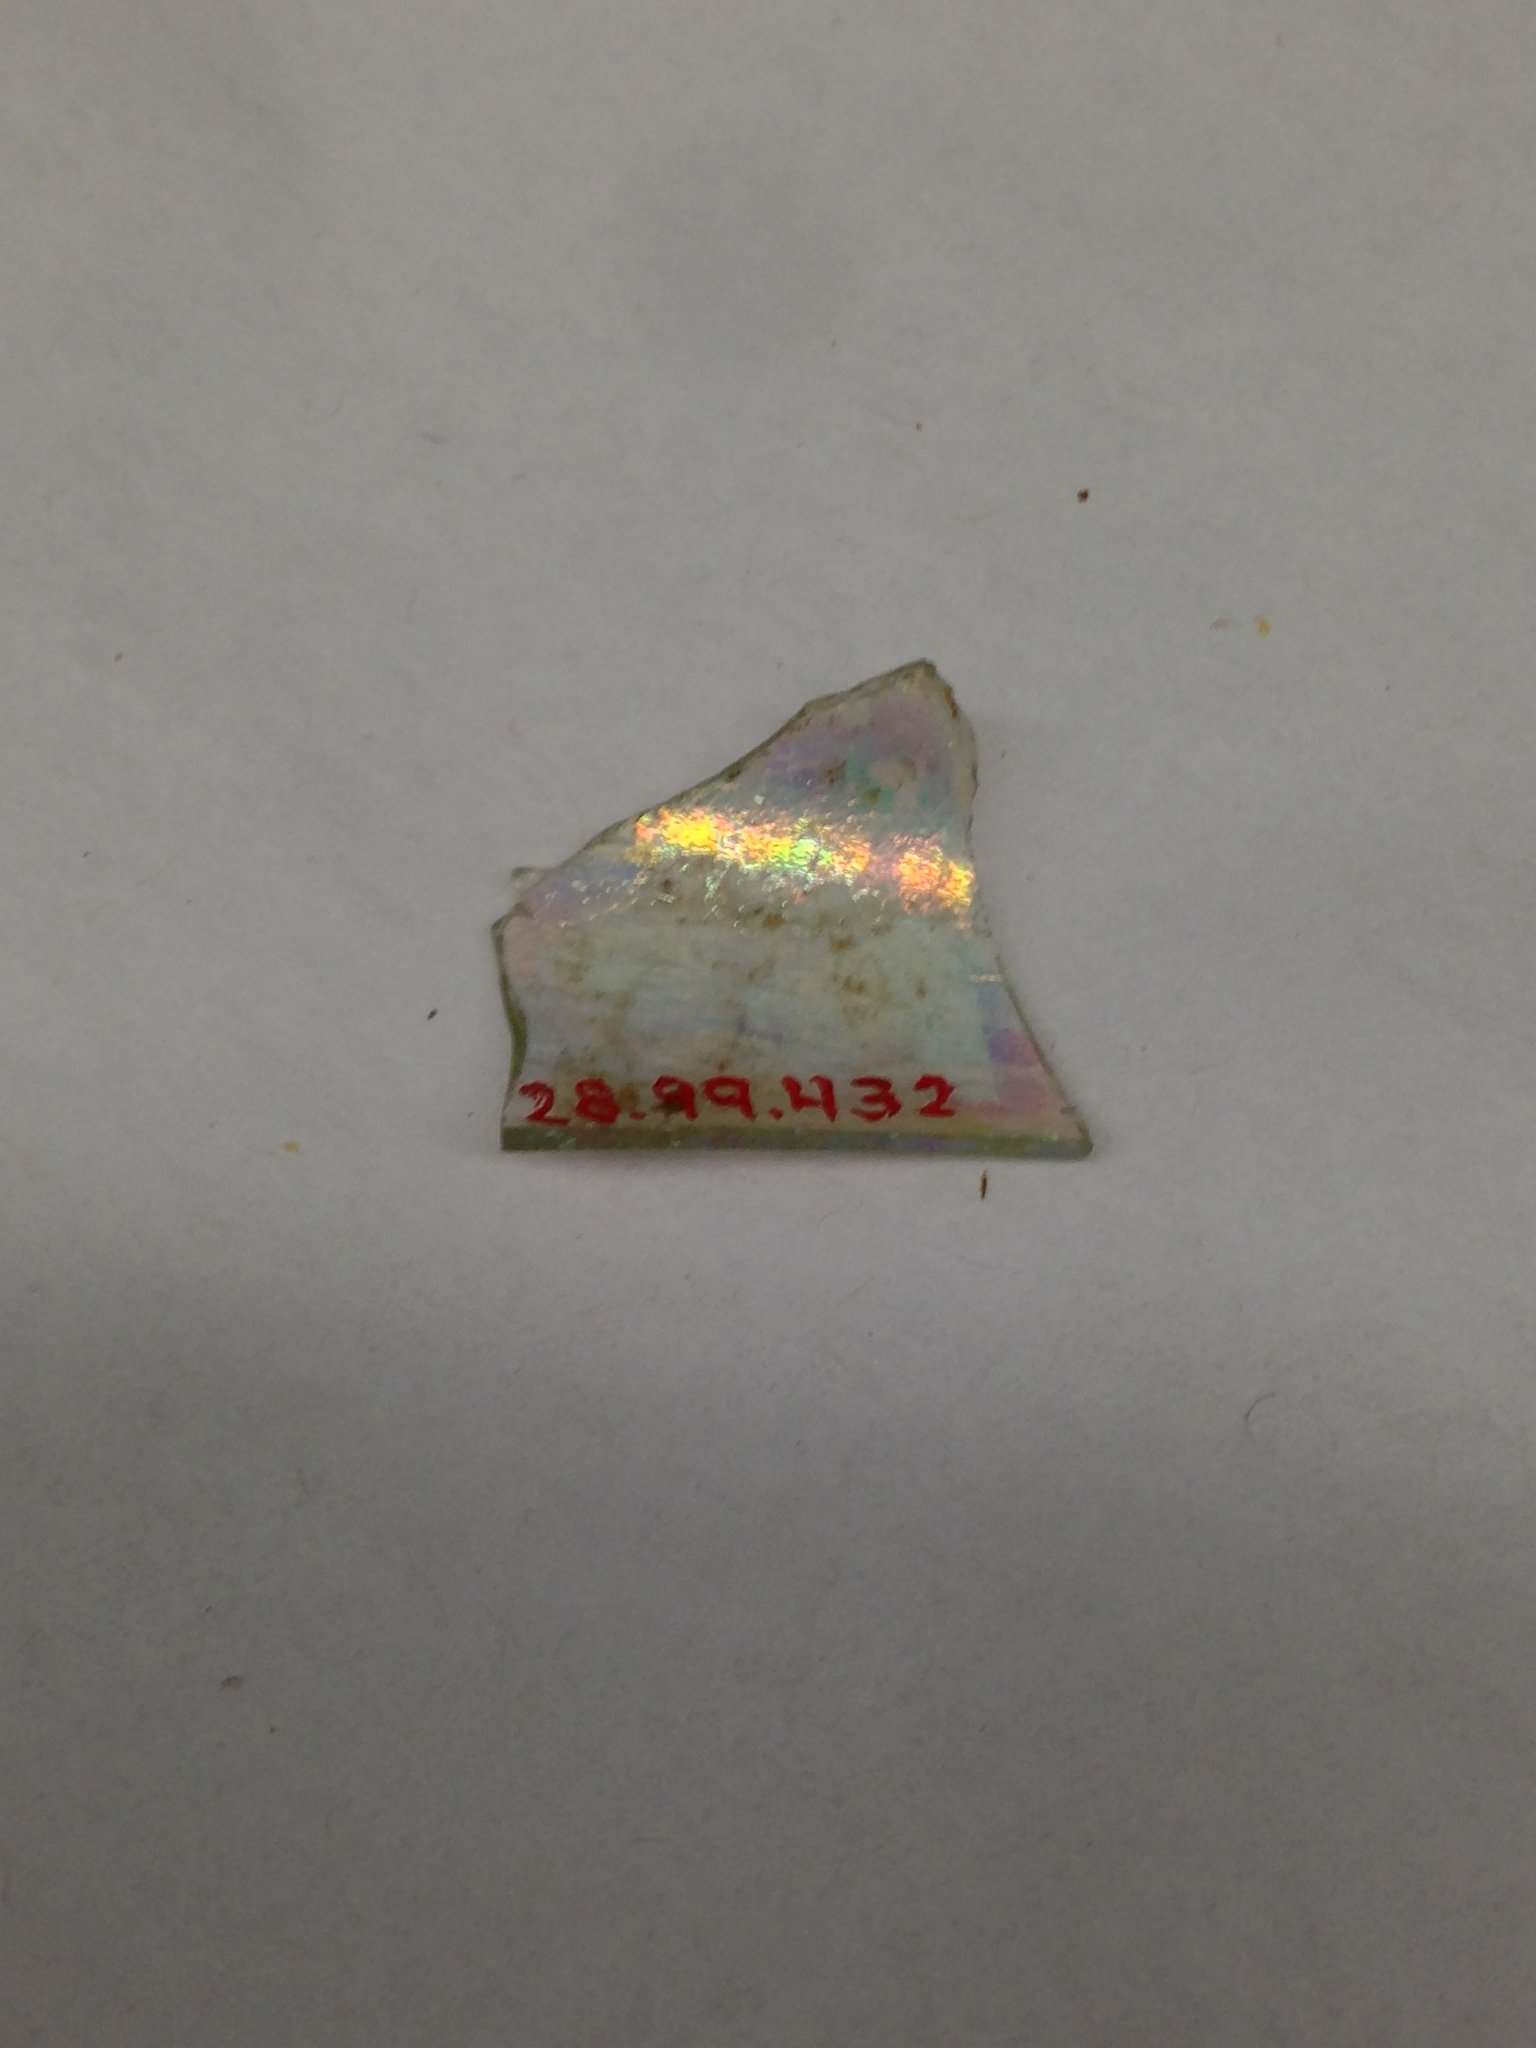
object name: fragment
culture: european or middle eastern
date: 1150-1250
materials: ceramic, glass